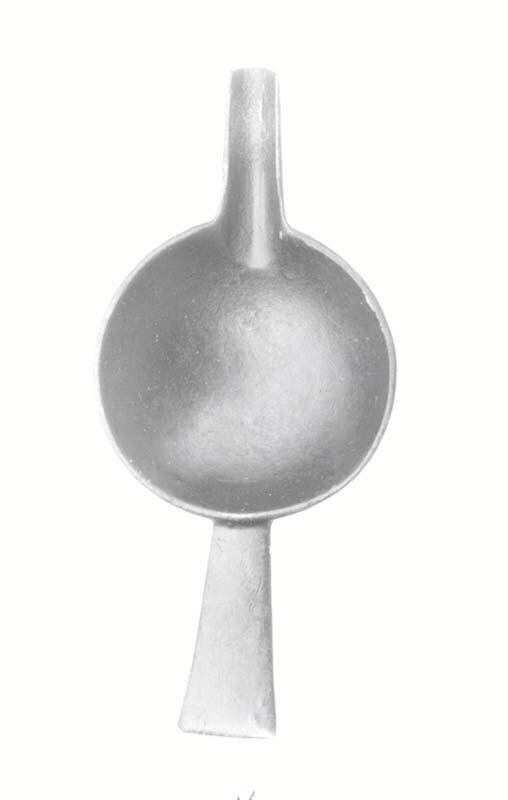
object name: dropper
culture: sasanian or islamic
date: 601-1000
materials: bronze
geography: iran